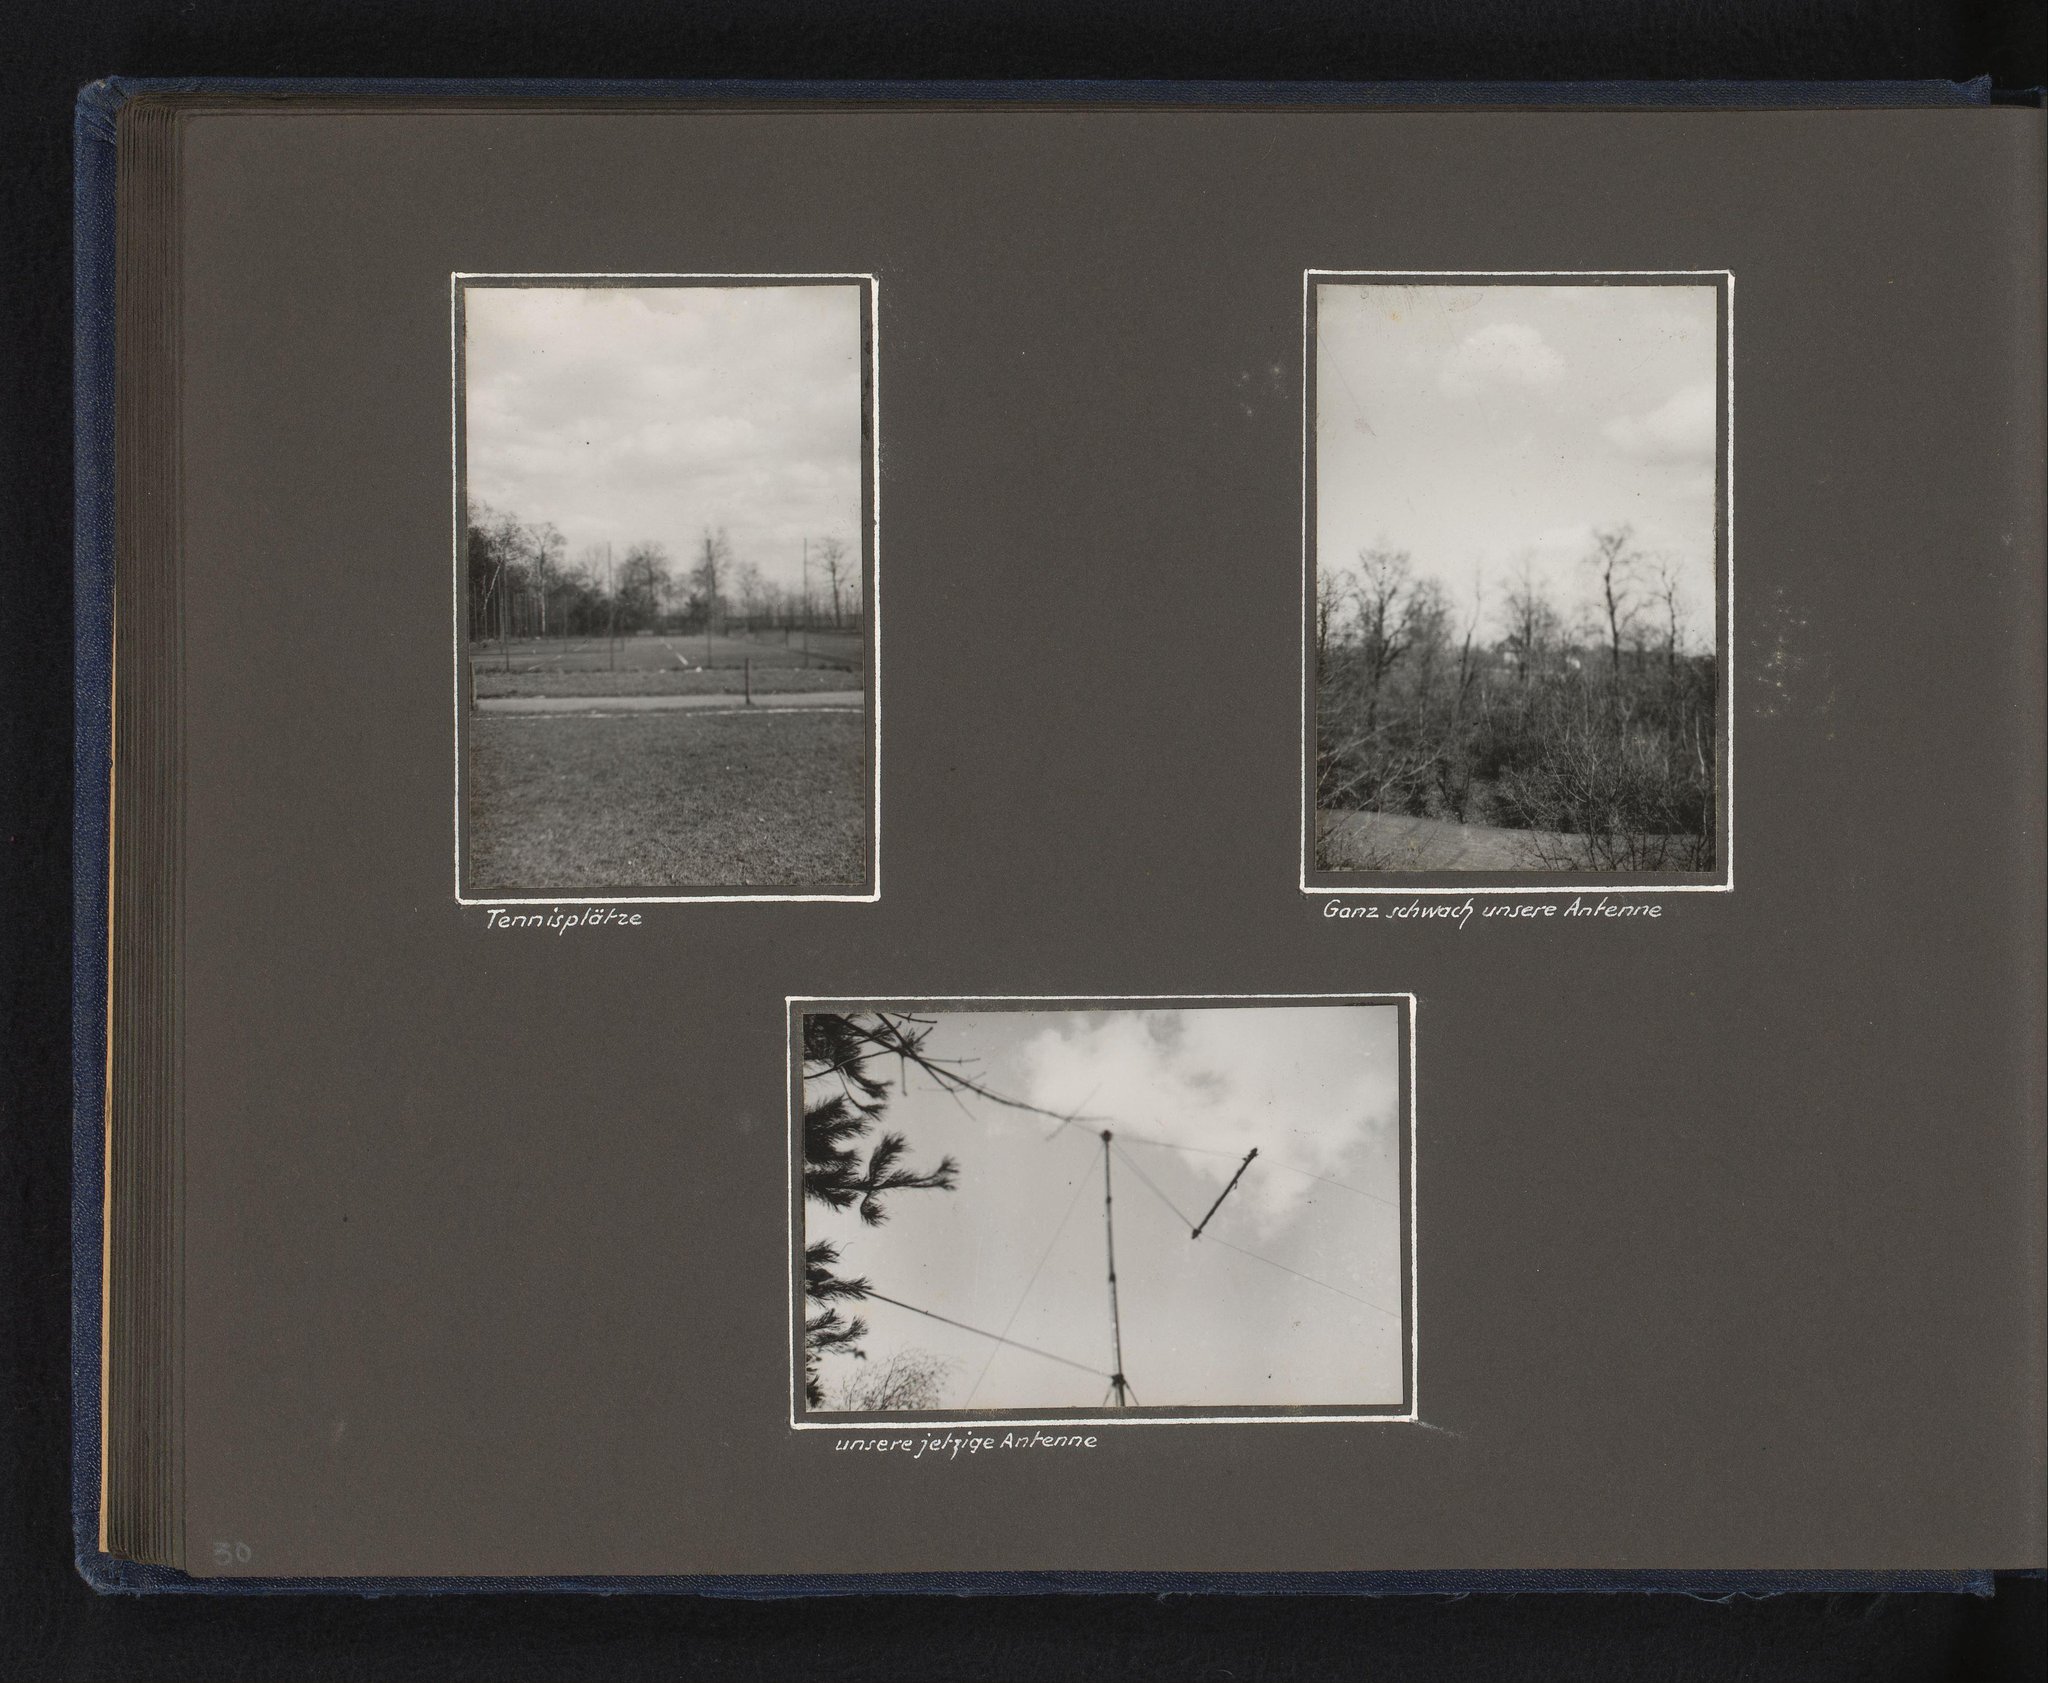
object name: photograph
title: Antenne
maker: Anonymous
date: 1940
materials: paper, photographic support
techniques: gelatin silver print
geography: germany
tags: telecommunications tower, antenna tower, radio mast, television tower, tv tower, communication (military), germany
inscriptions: inscription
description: Albumblad met drie foto's van de radioantenne en van de tennisbaan te Bocklemünd, voorjaar 1940. Onderdeel van een Duits militair album Tweede Wereldoorlog 1939-1940.